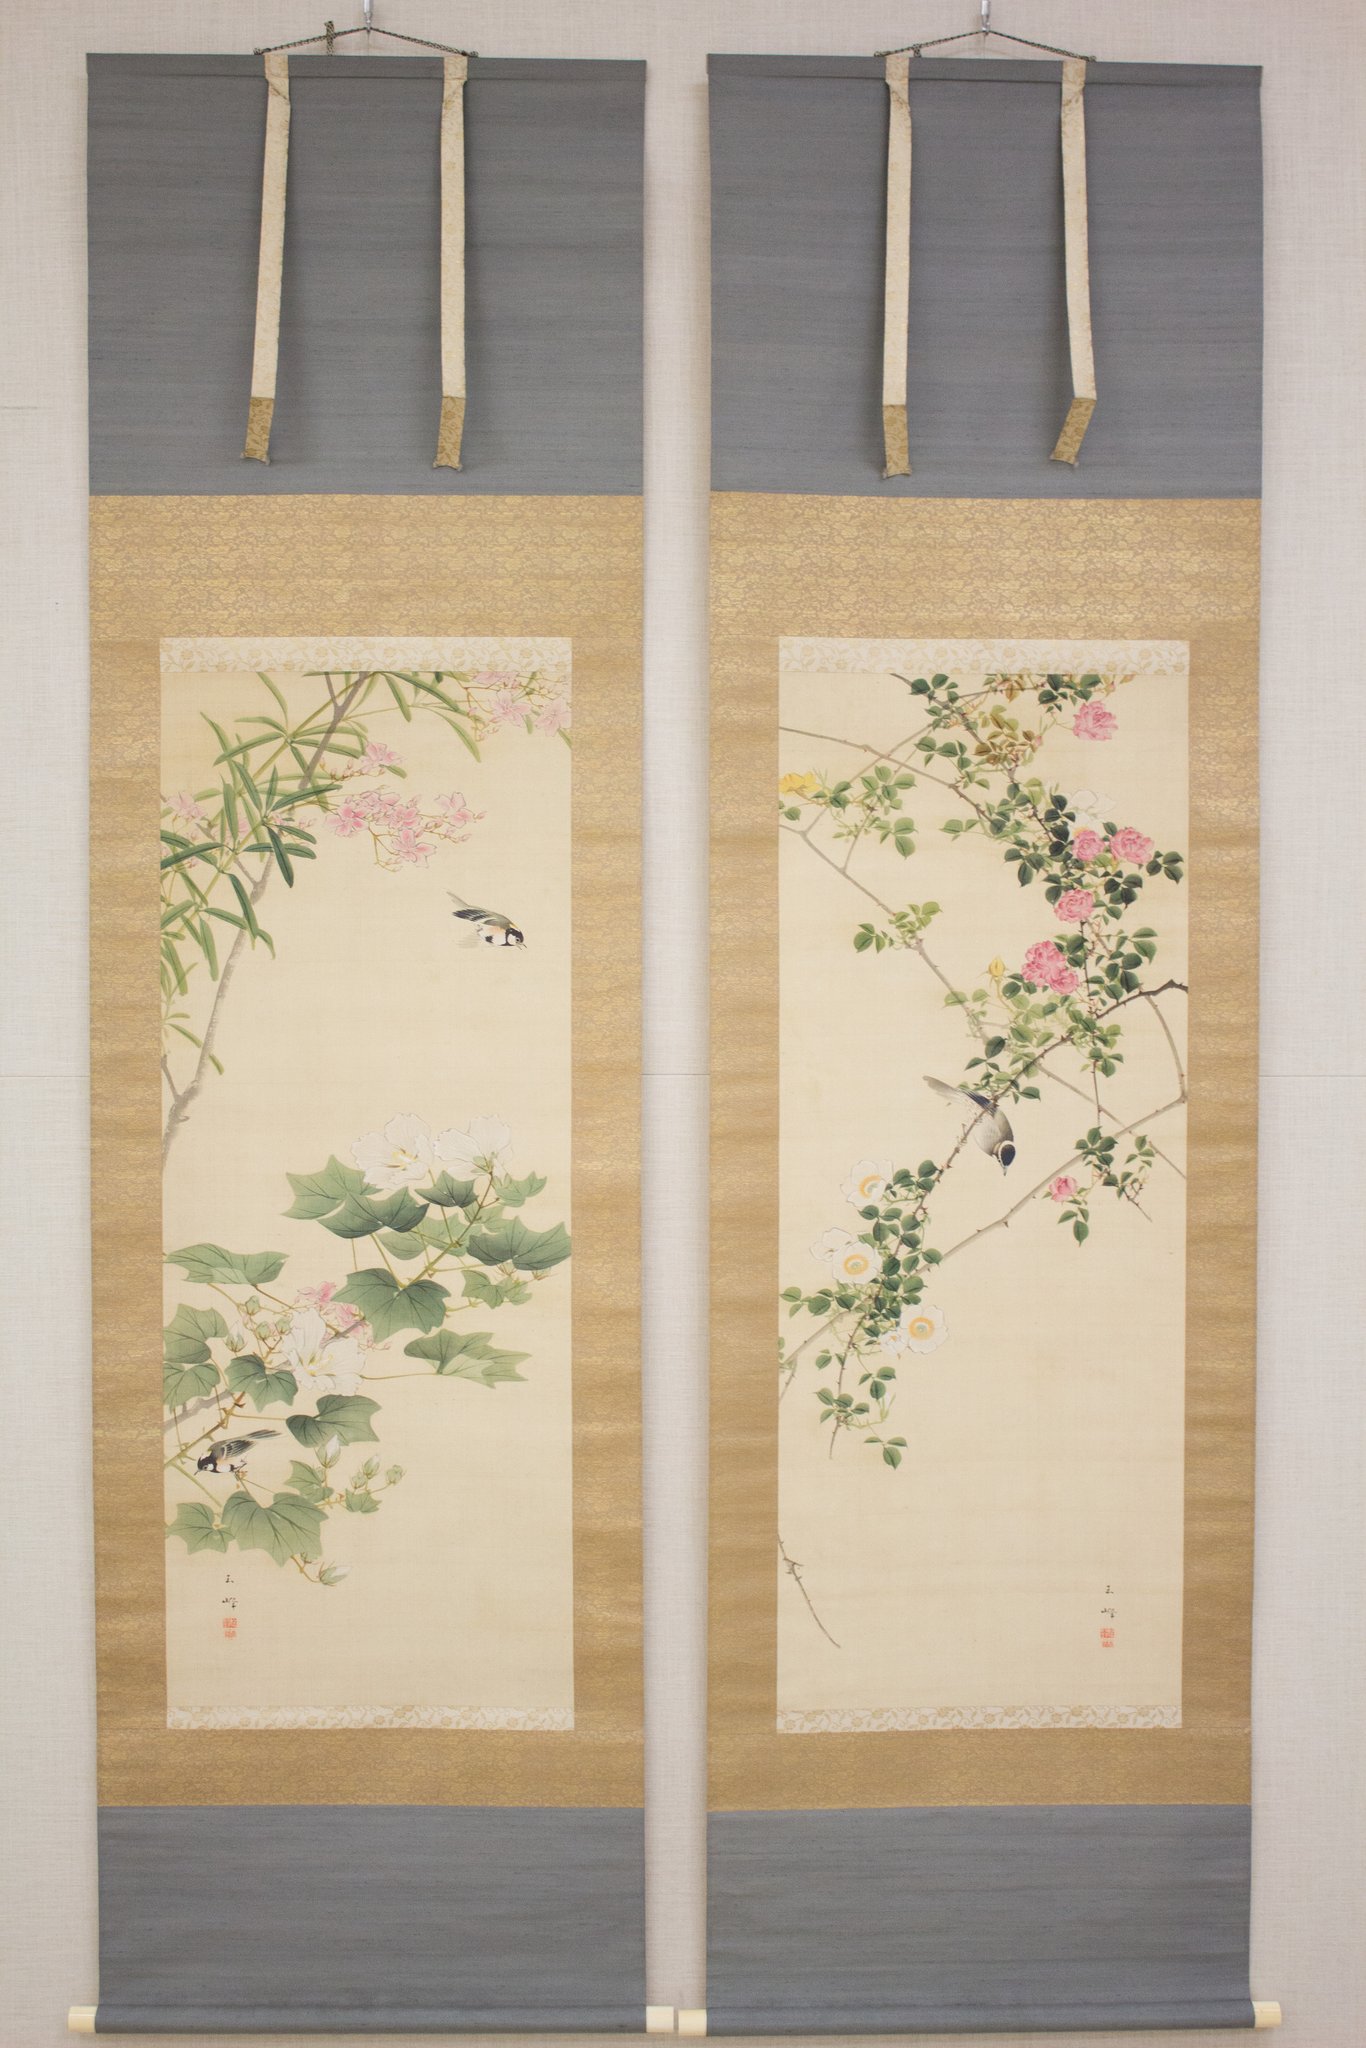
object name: hanging scroll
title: Roses and Field Sparrow (?)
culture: japanese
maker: hasegawa gyokuhō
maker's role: artist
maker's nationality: japanese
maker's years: 1822-1879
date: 1801-1900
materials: ink, silk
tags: birds,flowers